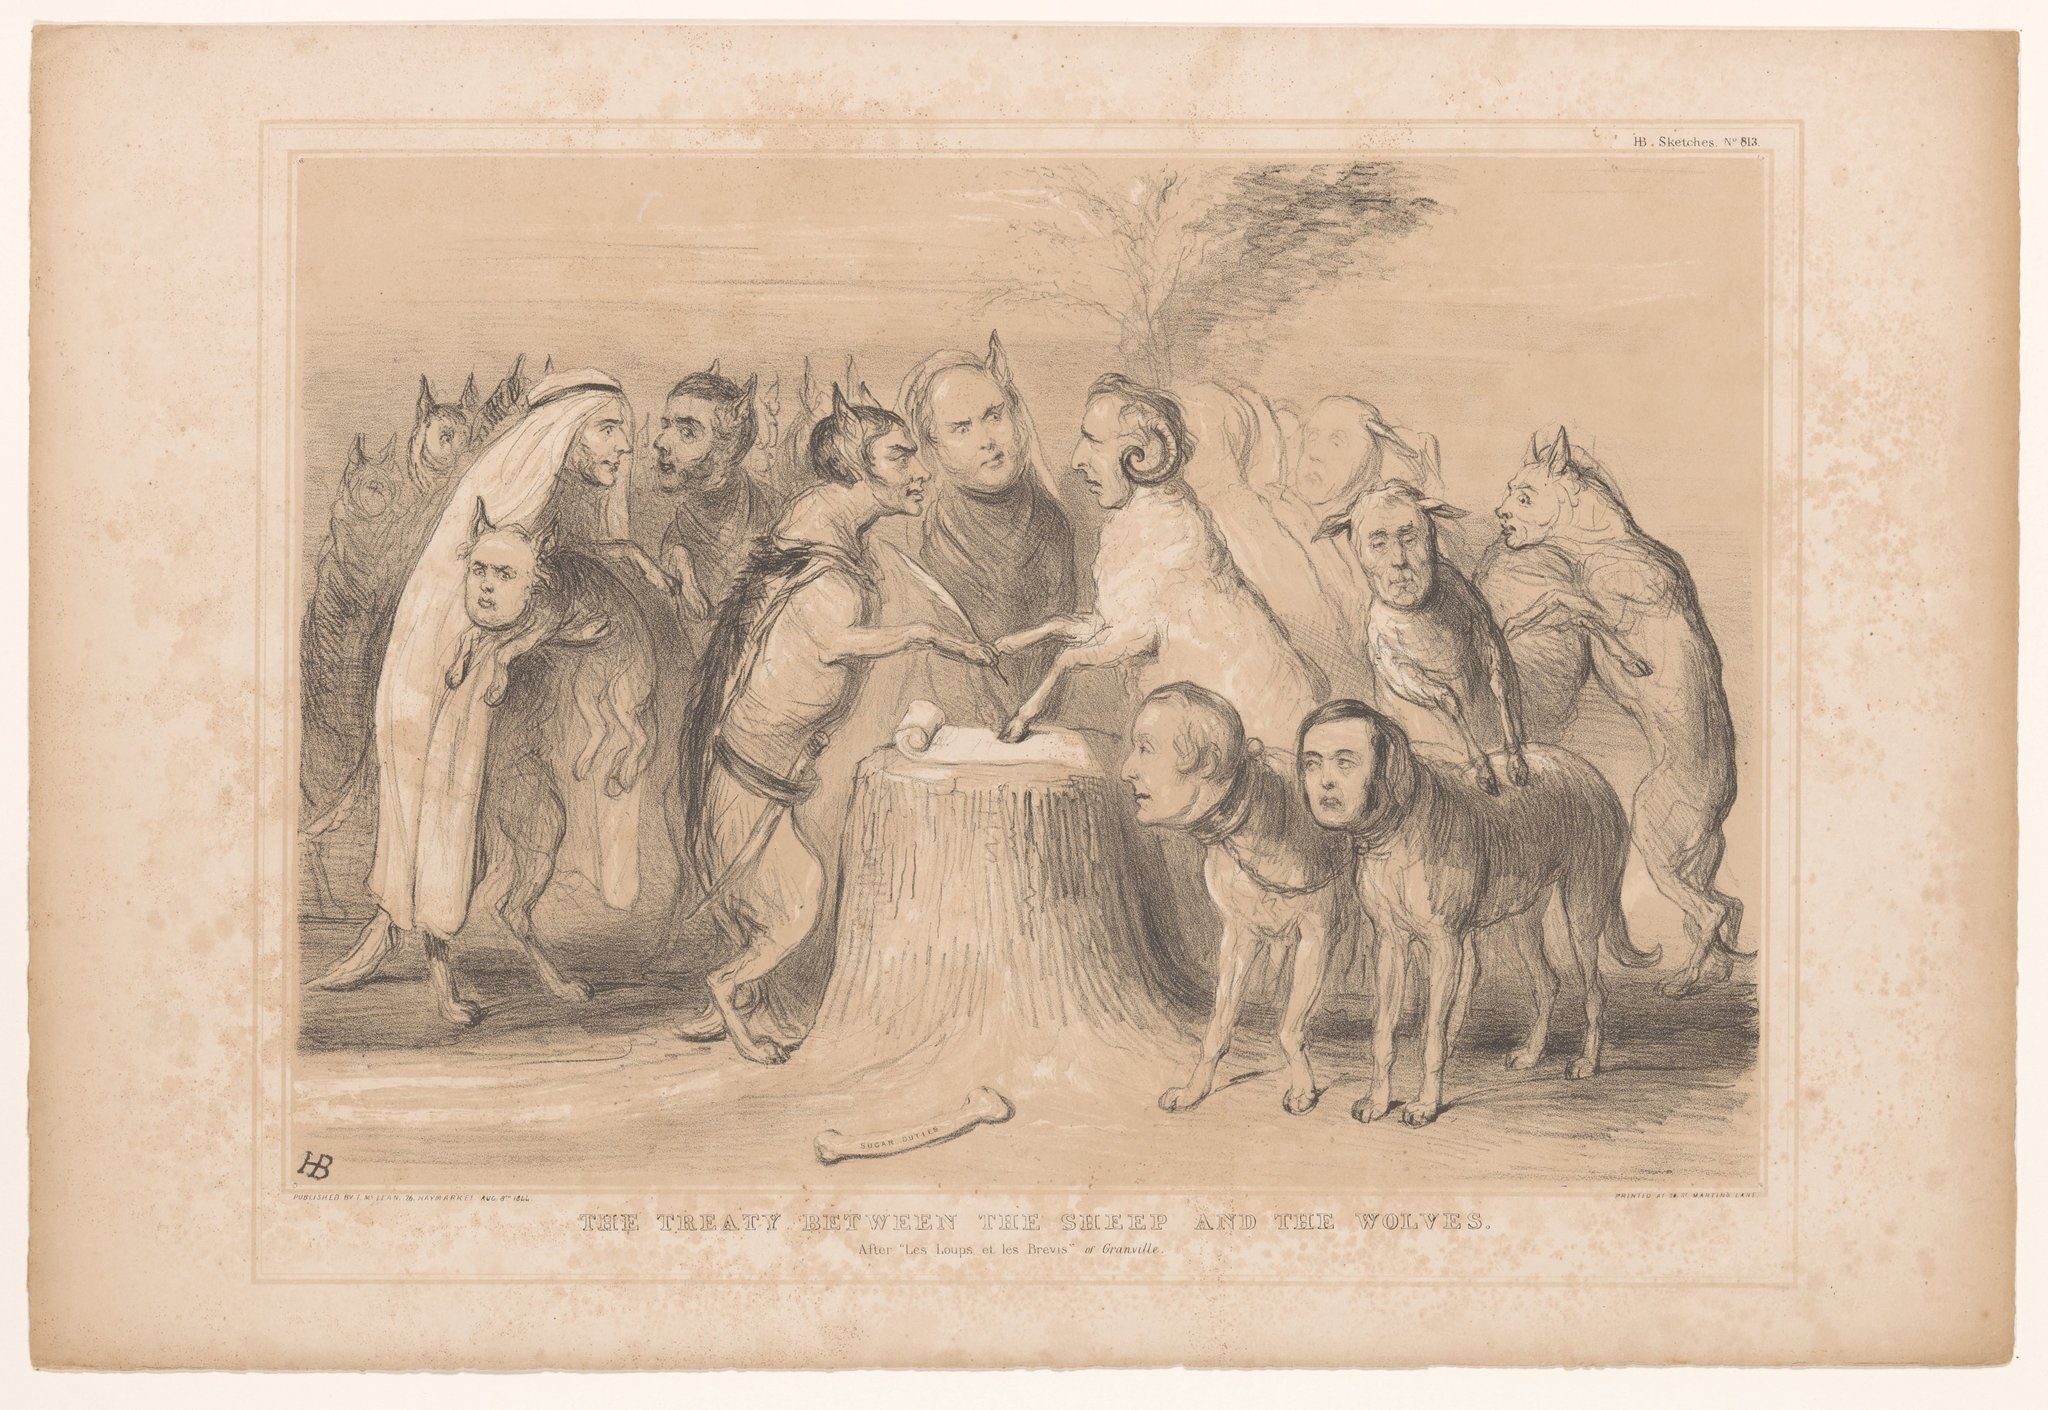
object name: cartoon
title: The treaty between the sheep and the wolves. After "Les Loups et les Brevis" of Granville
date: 1844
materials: paper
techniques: tone lithography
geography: england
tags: political caricatures and satires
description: Spotprent op de Engelse binnenlandse politiek in 1844 waarin de wolven en de schapen een pact sluiten tegen de honden. Uitgegeven als nr. 813 in de serie HB Sketches.